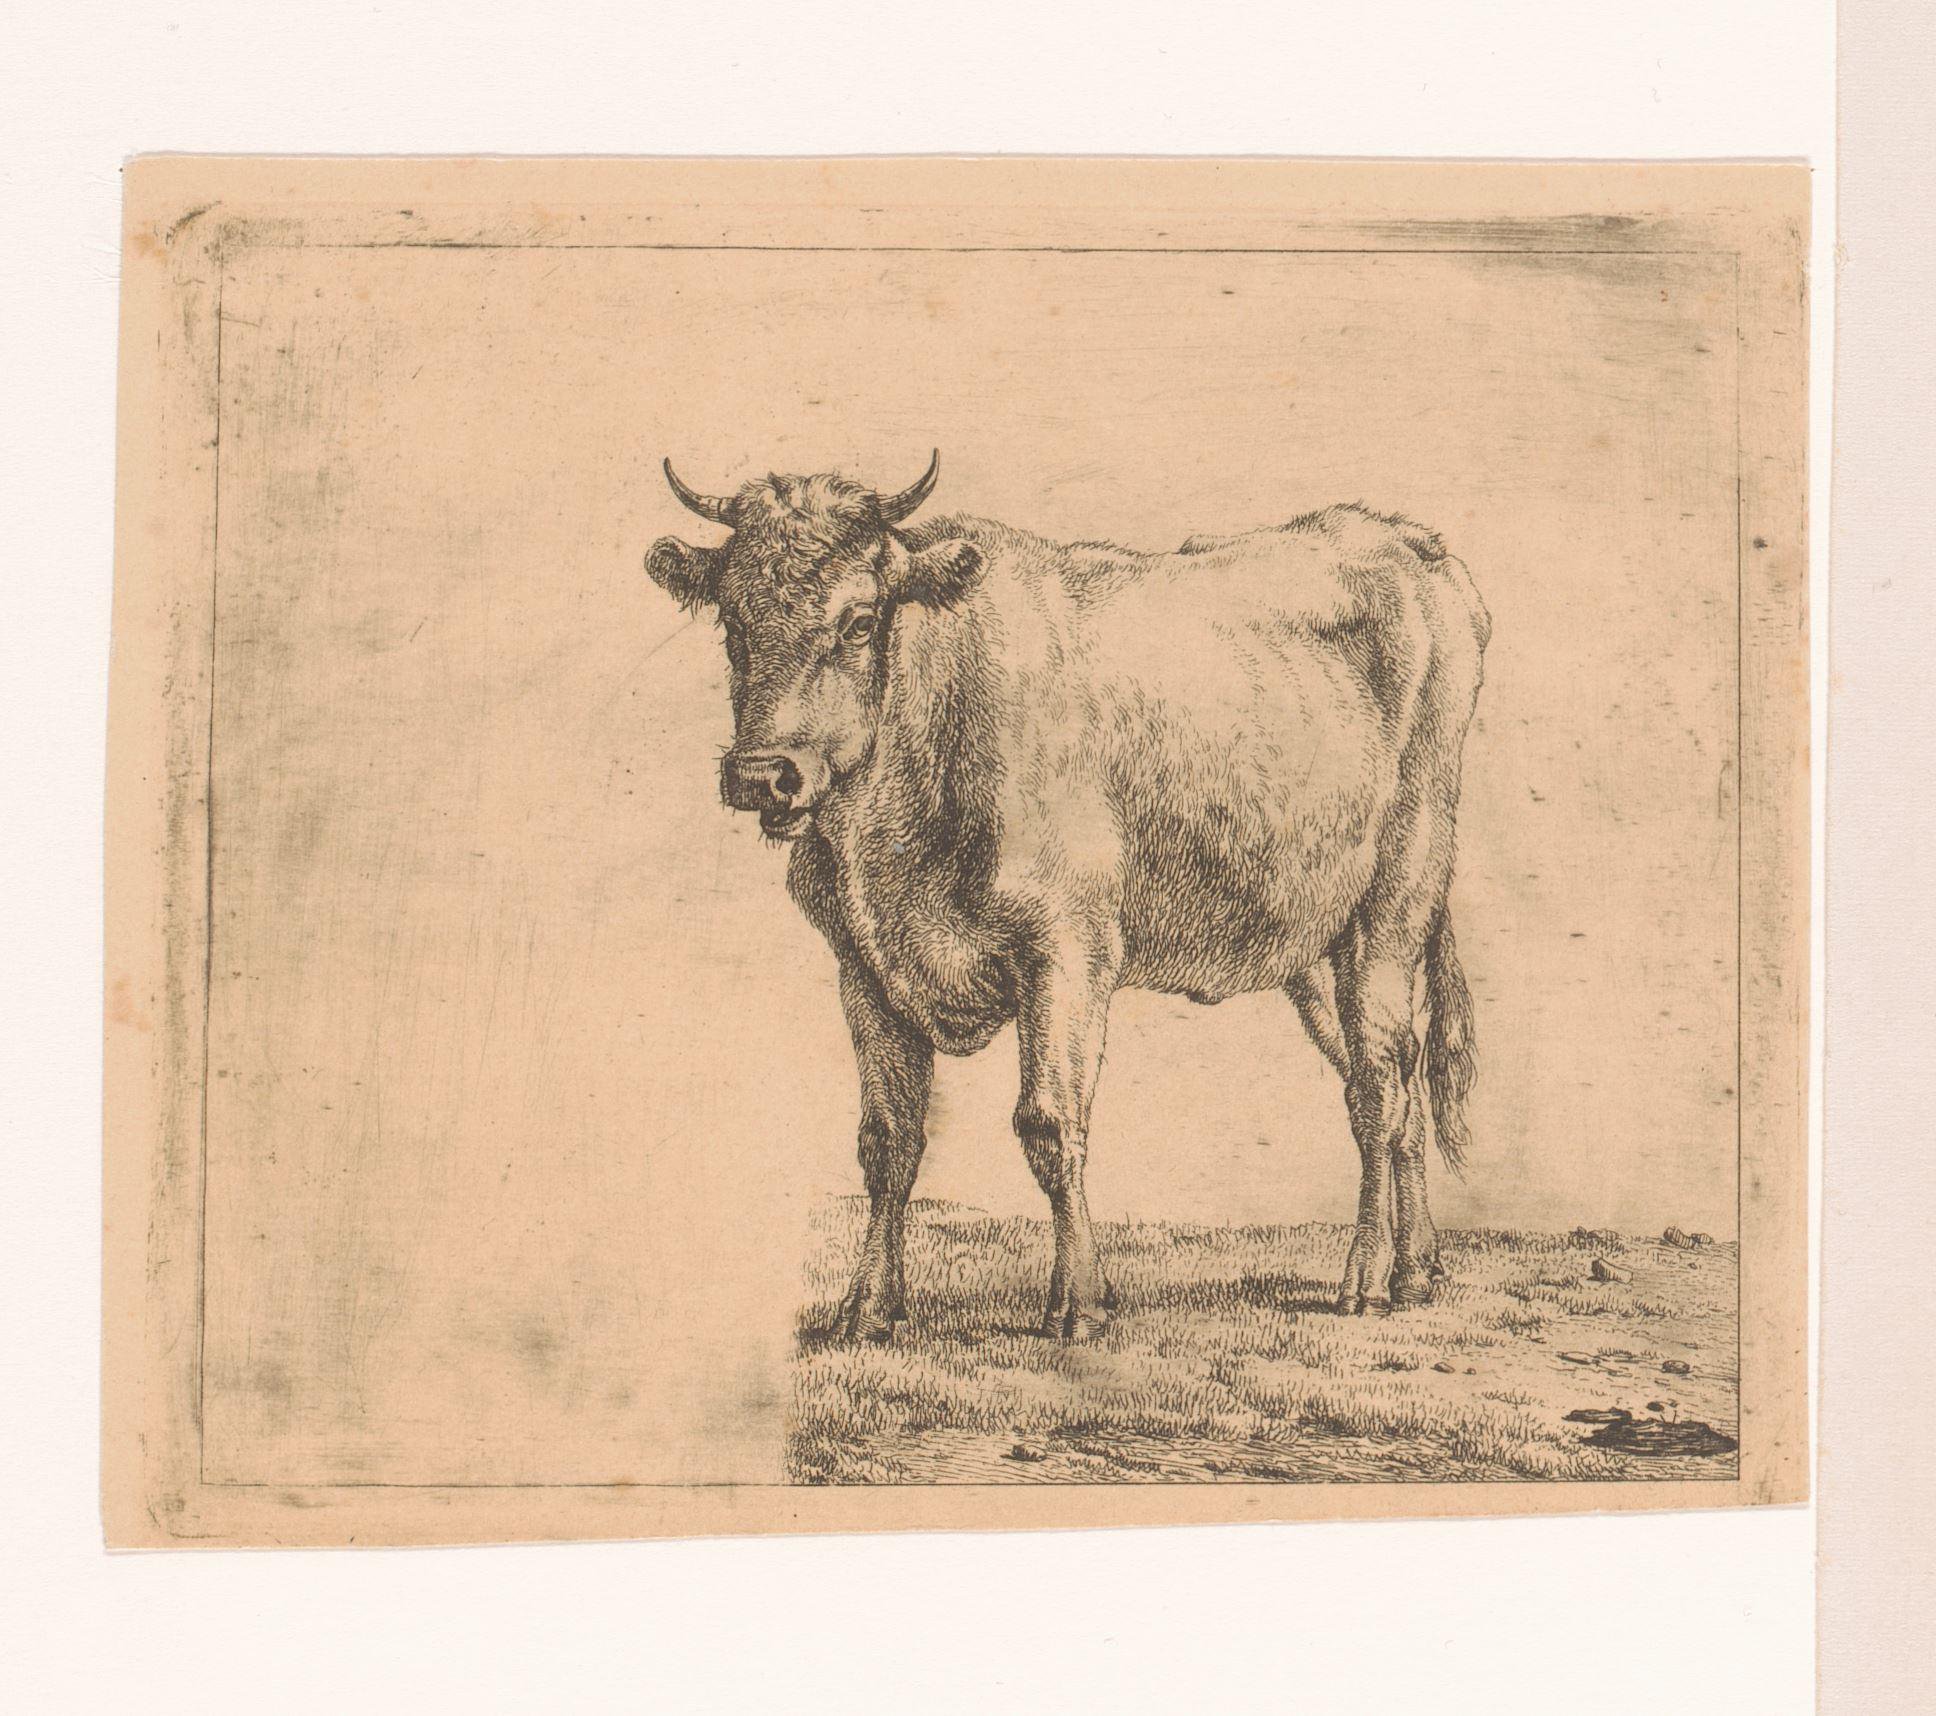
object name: print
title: Staande koe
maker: eugène verboeckhoven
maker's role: draughtsman, painter, print maker, printer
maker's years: 1798-1881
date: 1830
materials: paper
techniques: etching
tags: cow